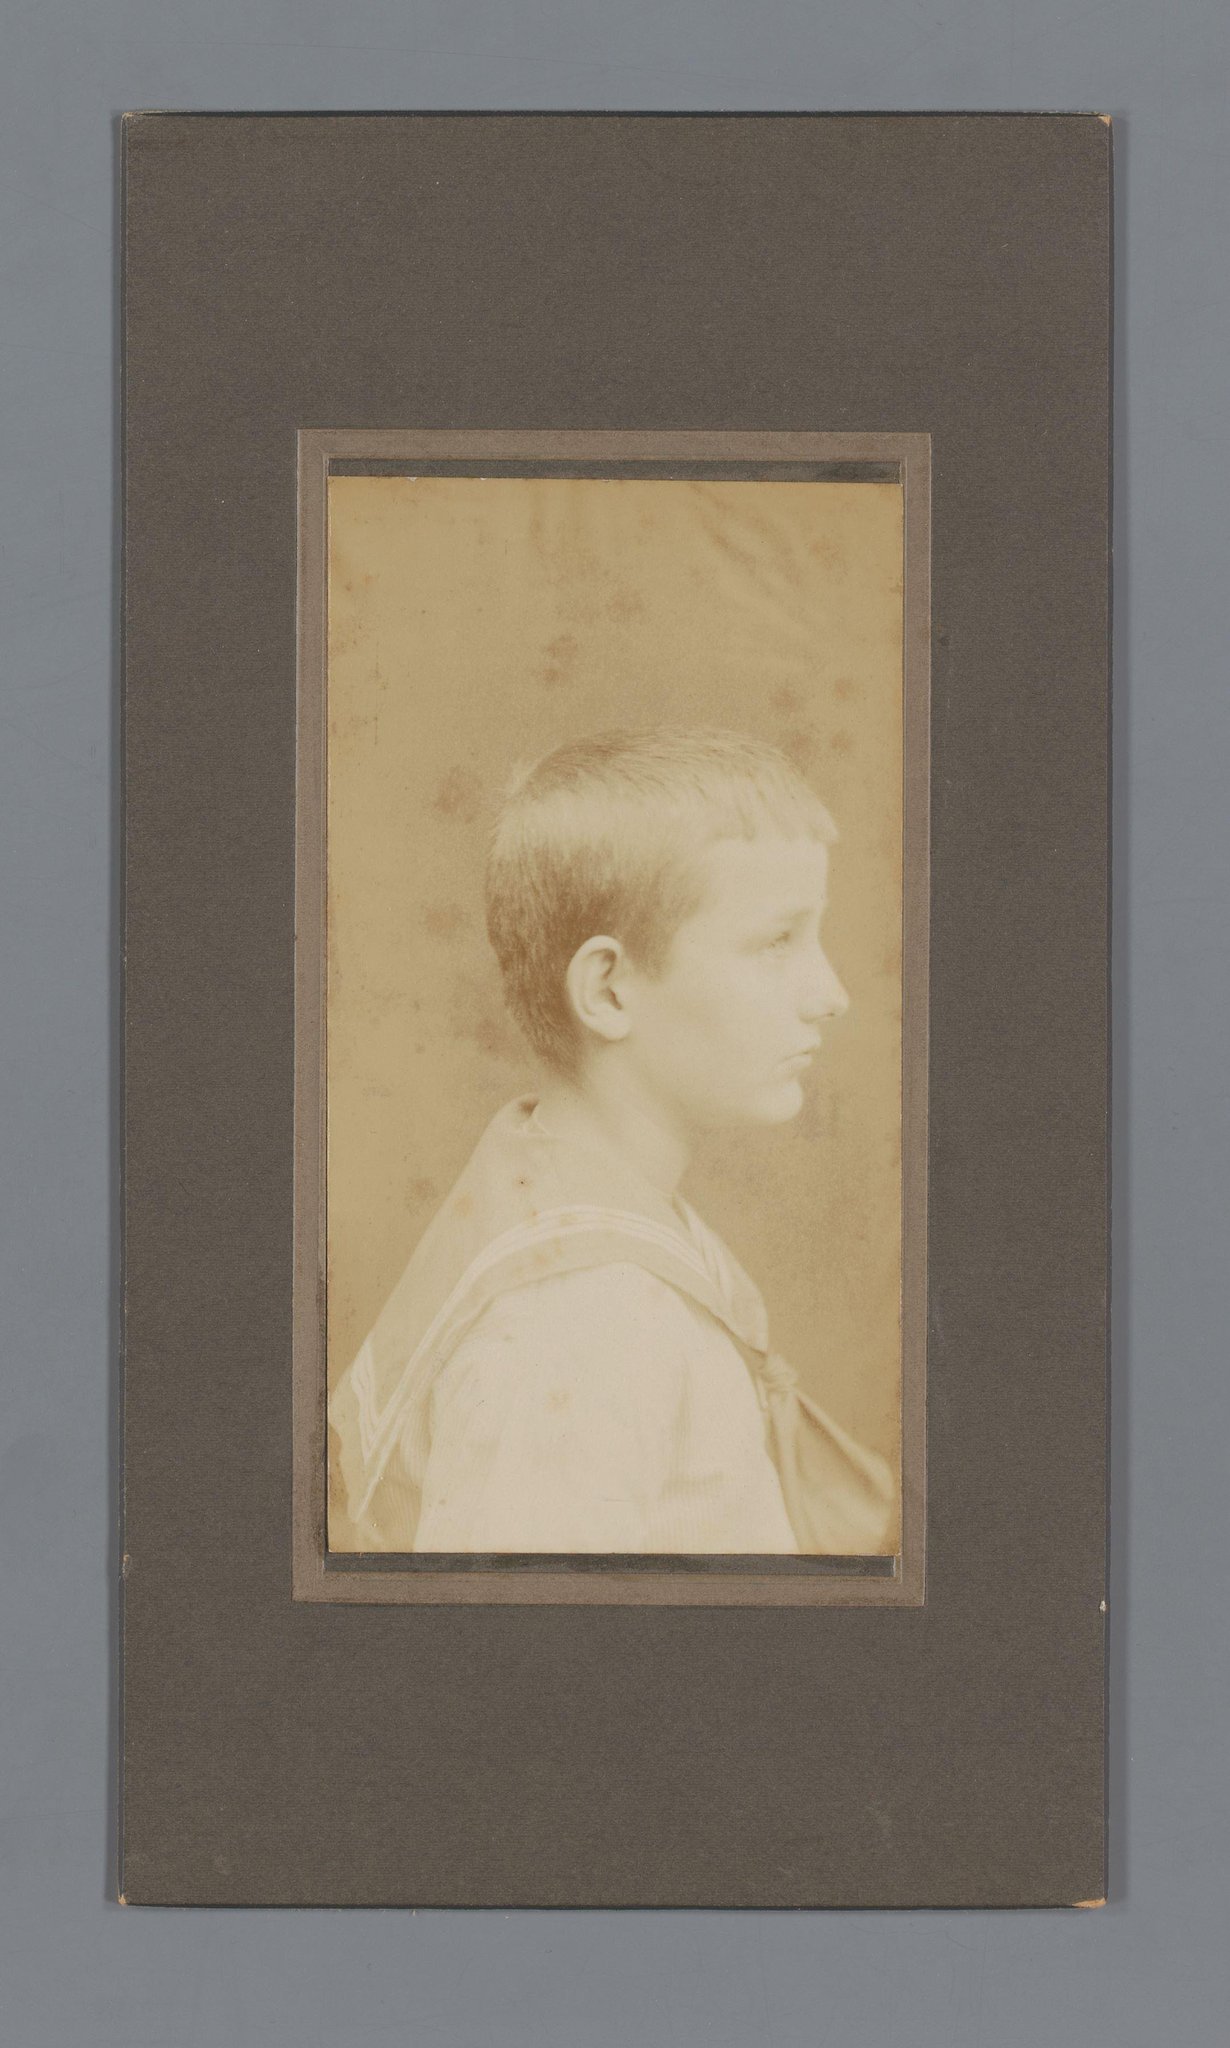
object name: photograph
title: Portret van Willem Nije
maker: cornelia hendrika jonker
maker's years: 1874-1924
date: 1850-1900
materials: cardboard, photographic support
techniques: albumen print, hand coloring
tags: historical persons